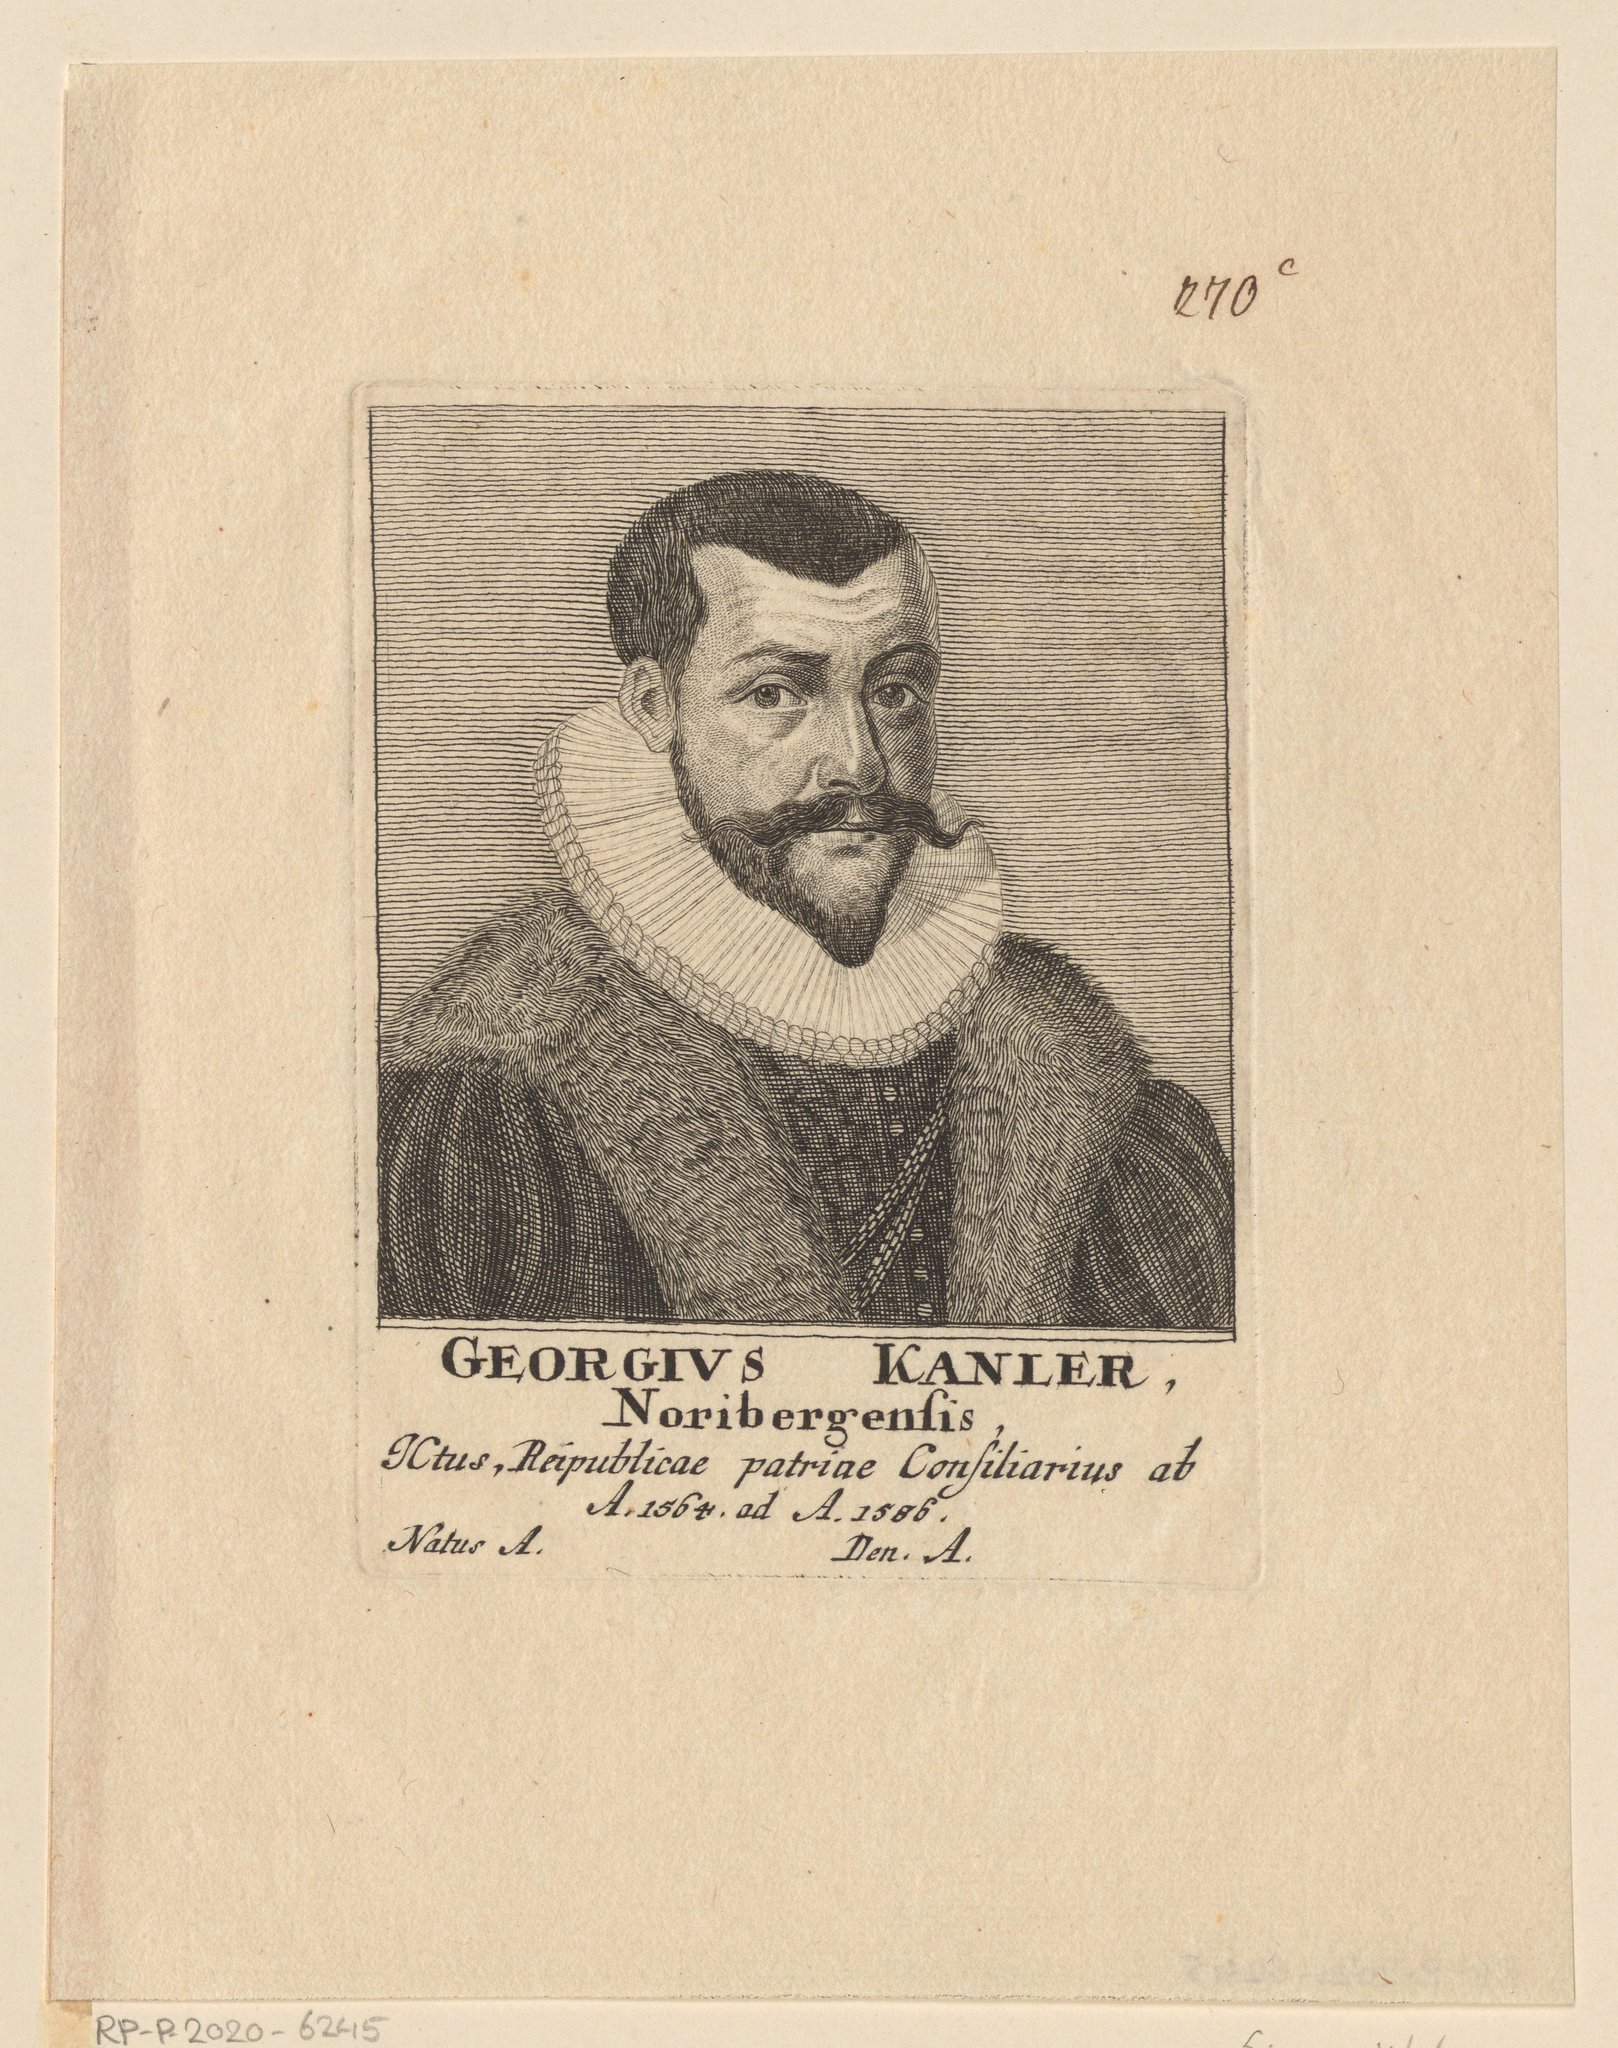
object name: print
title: Portret van Georg Kanler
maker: Anonymous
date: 1725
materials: paper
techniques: engraving, etching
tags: historical persons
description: Prent mogelijk uit: Rothscholtz, Friedrich. Icones virorum omnium ordinum eruditione: omnique item genere et varietate artium de republica litteraria et speciatim de Academiis et Gymnasiis (...). Neurenberg: erven Johann Daniel Tauber, 1725.